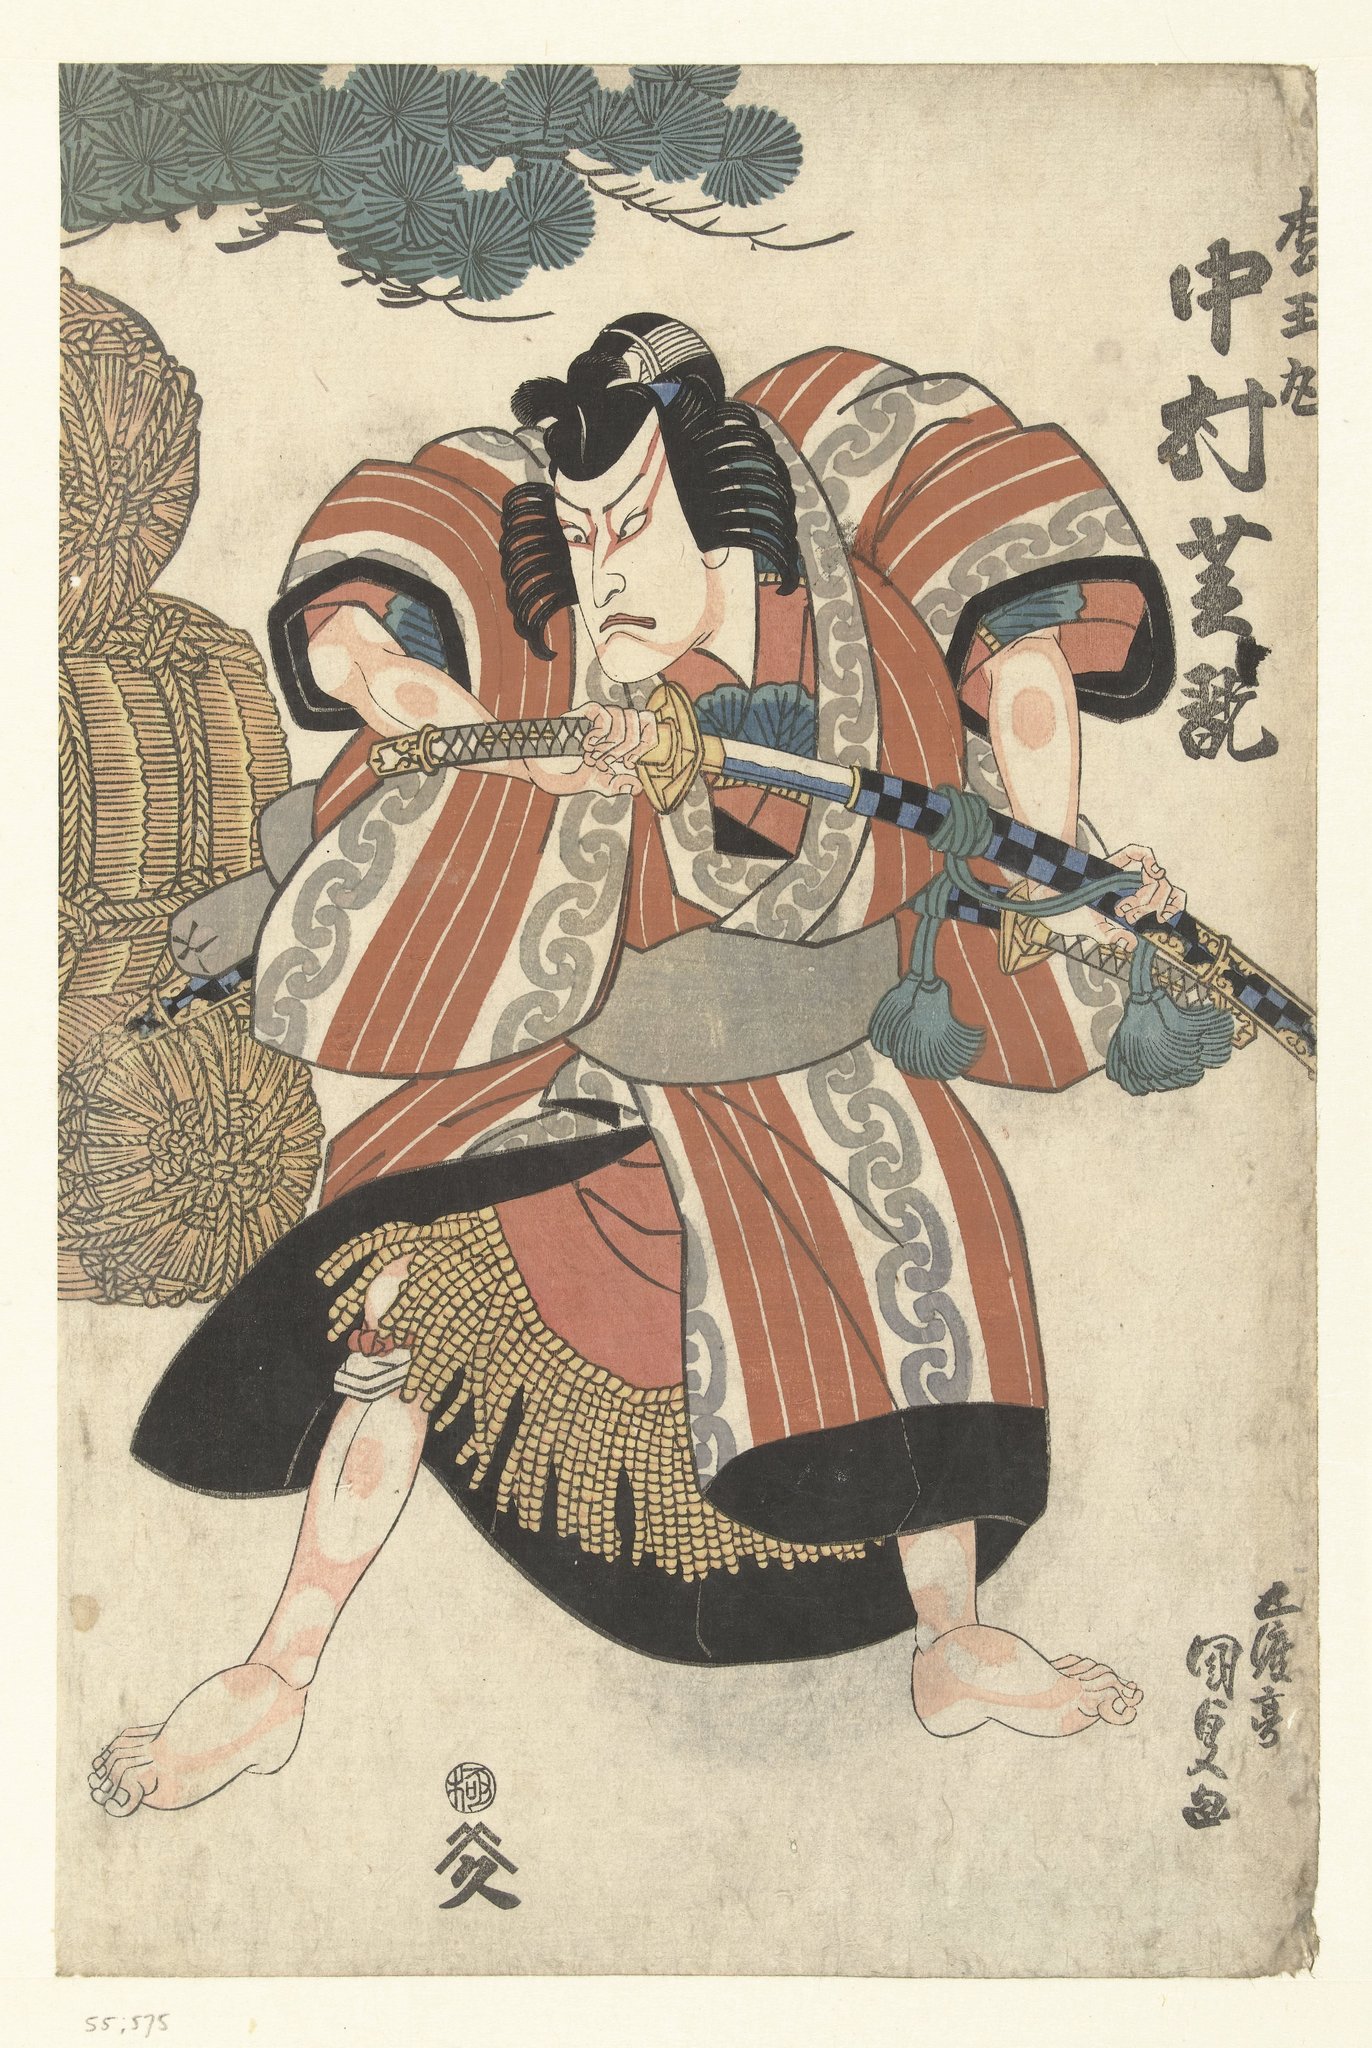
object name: print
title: Matsuomaru, Nakamura Shikan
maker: utagawa kunisada (i)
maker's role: print maker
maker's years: 1786-1865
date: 1825-1830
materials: paper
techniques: woodcut, nishiki e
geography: tokyo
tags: japan, hacking and thrusting weapons: sword, portrait of actor, actress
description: De acteur Nakamura Shikan II in rood gestreept gewaad, zijn zwaard trekkend; een pijnboomtak en opgestapelde strobalen op de achtergrond.